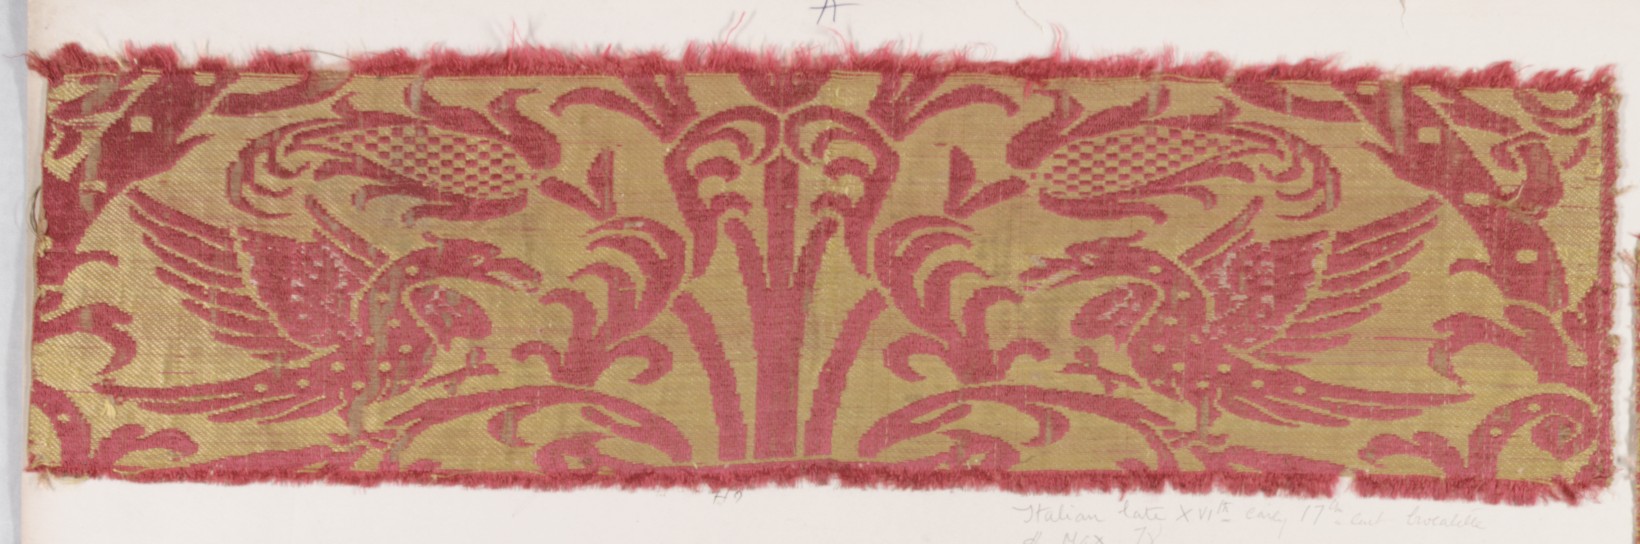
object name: fragment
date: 1501-1700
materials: silk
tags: birds,leaves